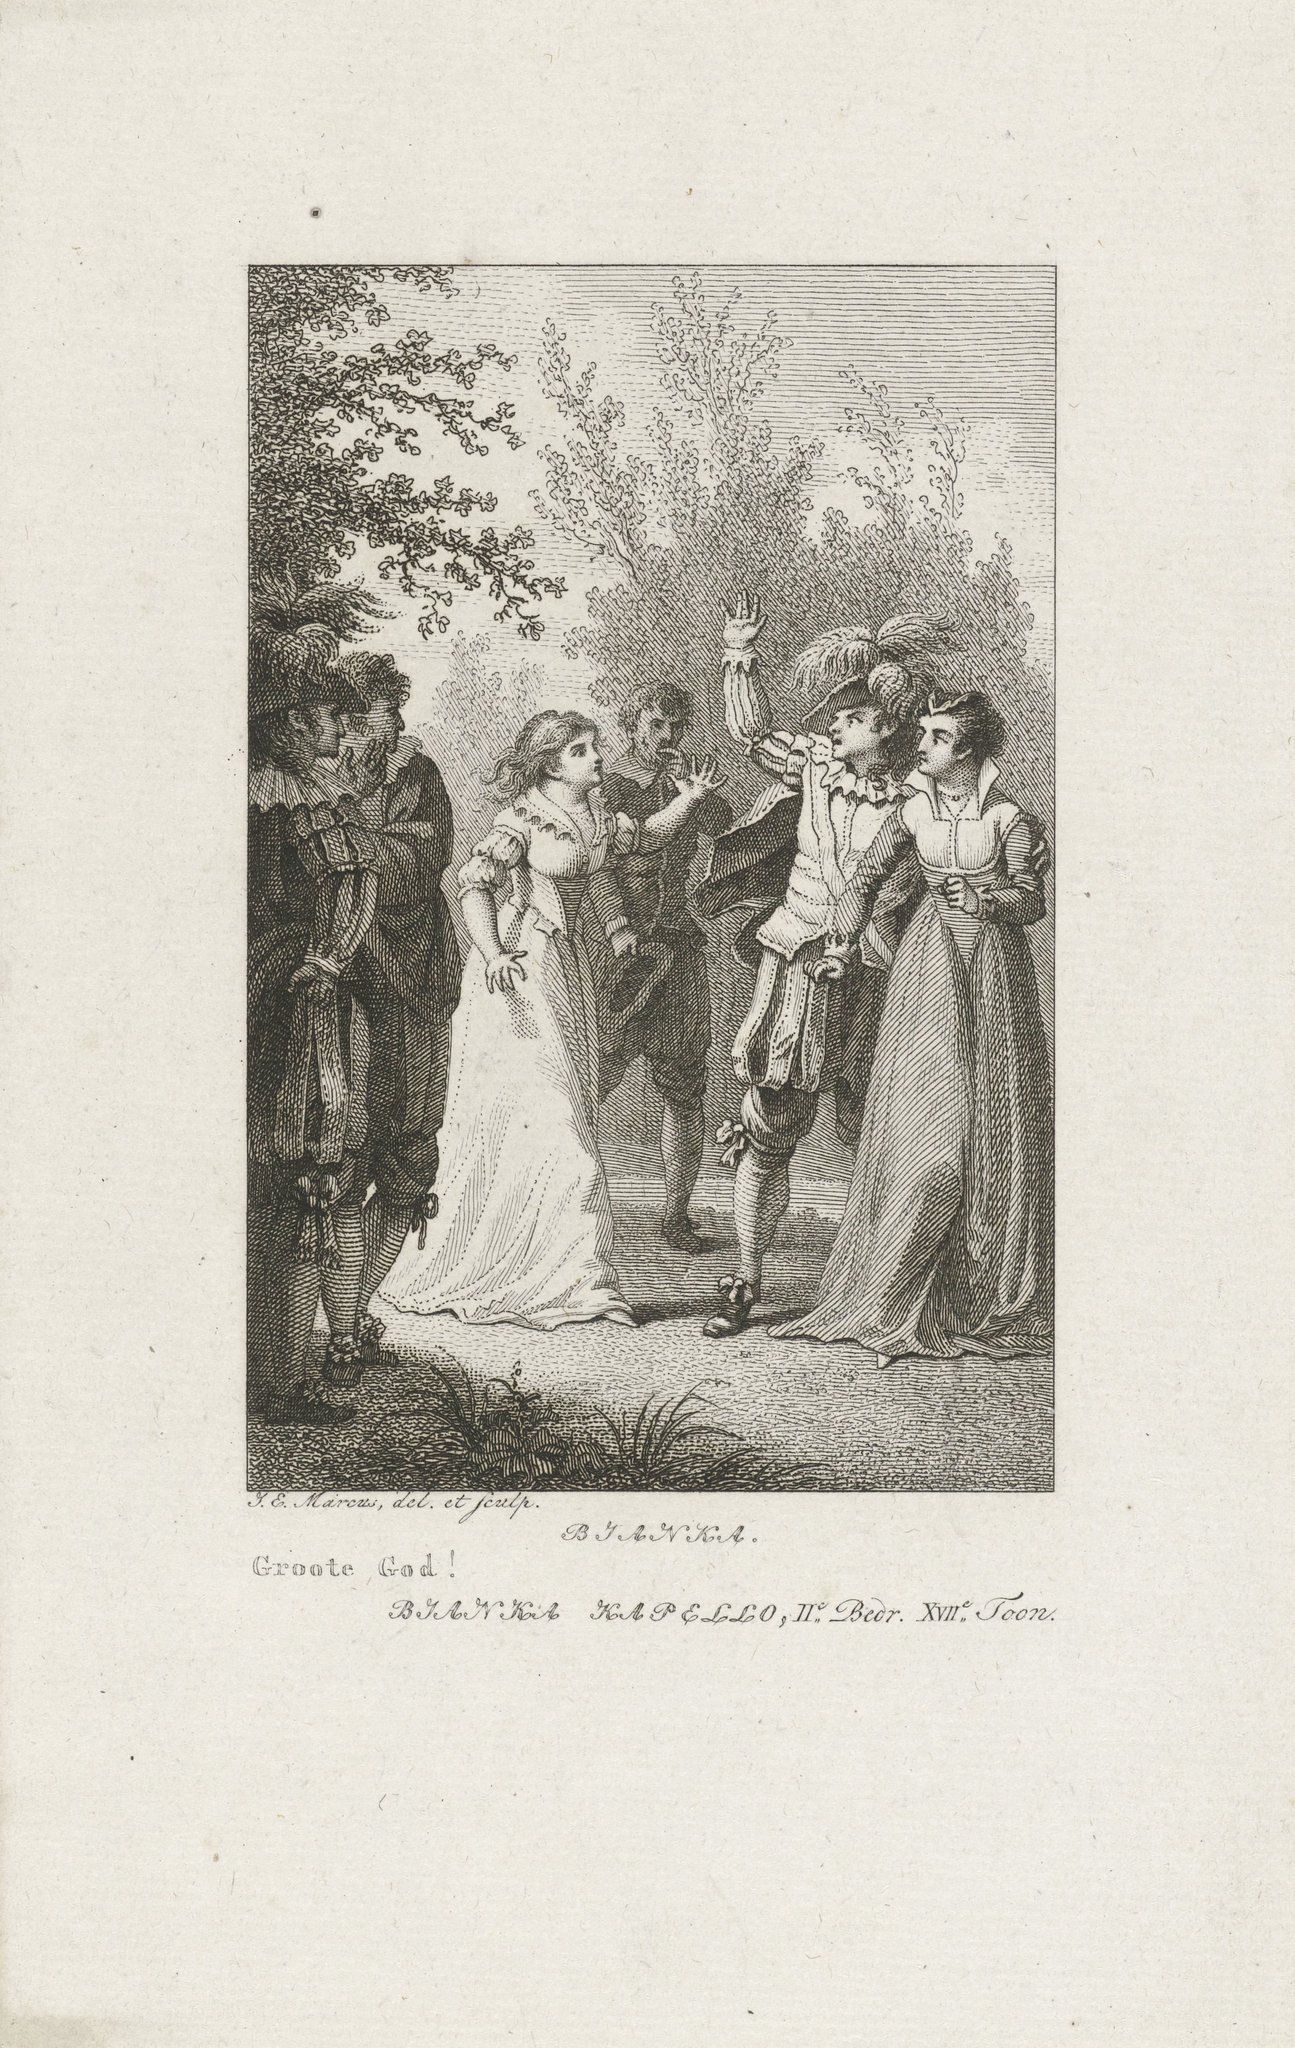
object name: print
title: Paar en een toesnellende vrouw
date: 1803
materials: paper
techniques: etching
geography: amsterdam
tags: arm raised upward, recognizing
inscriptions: collector's mark: Lugt 2228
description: In een landschap snelt een vrouw toe op een man die van schrik zijn arm opheft. Naast hem een vrouw. Het gezelschap is omringd door nog drie mannen. Rechtsonder gemerkt: IIe Bedr. XVIIIe Toon.